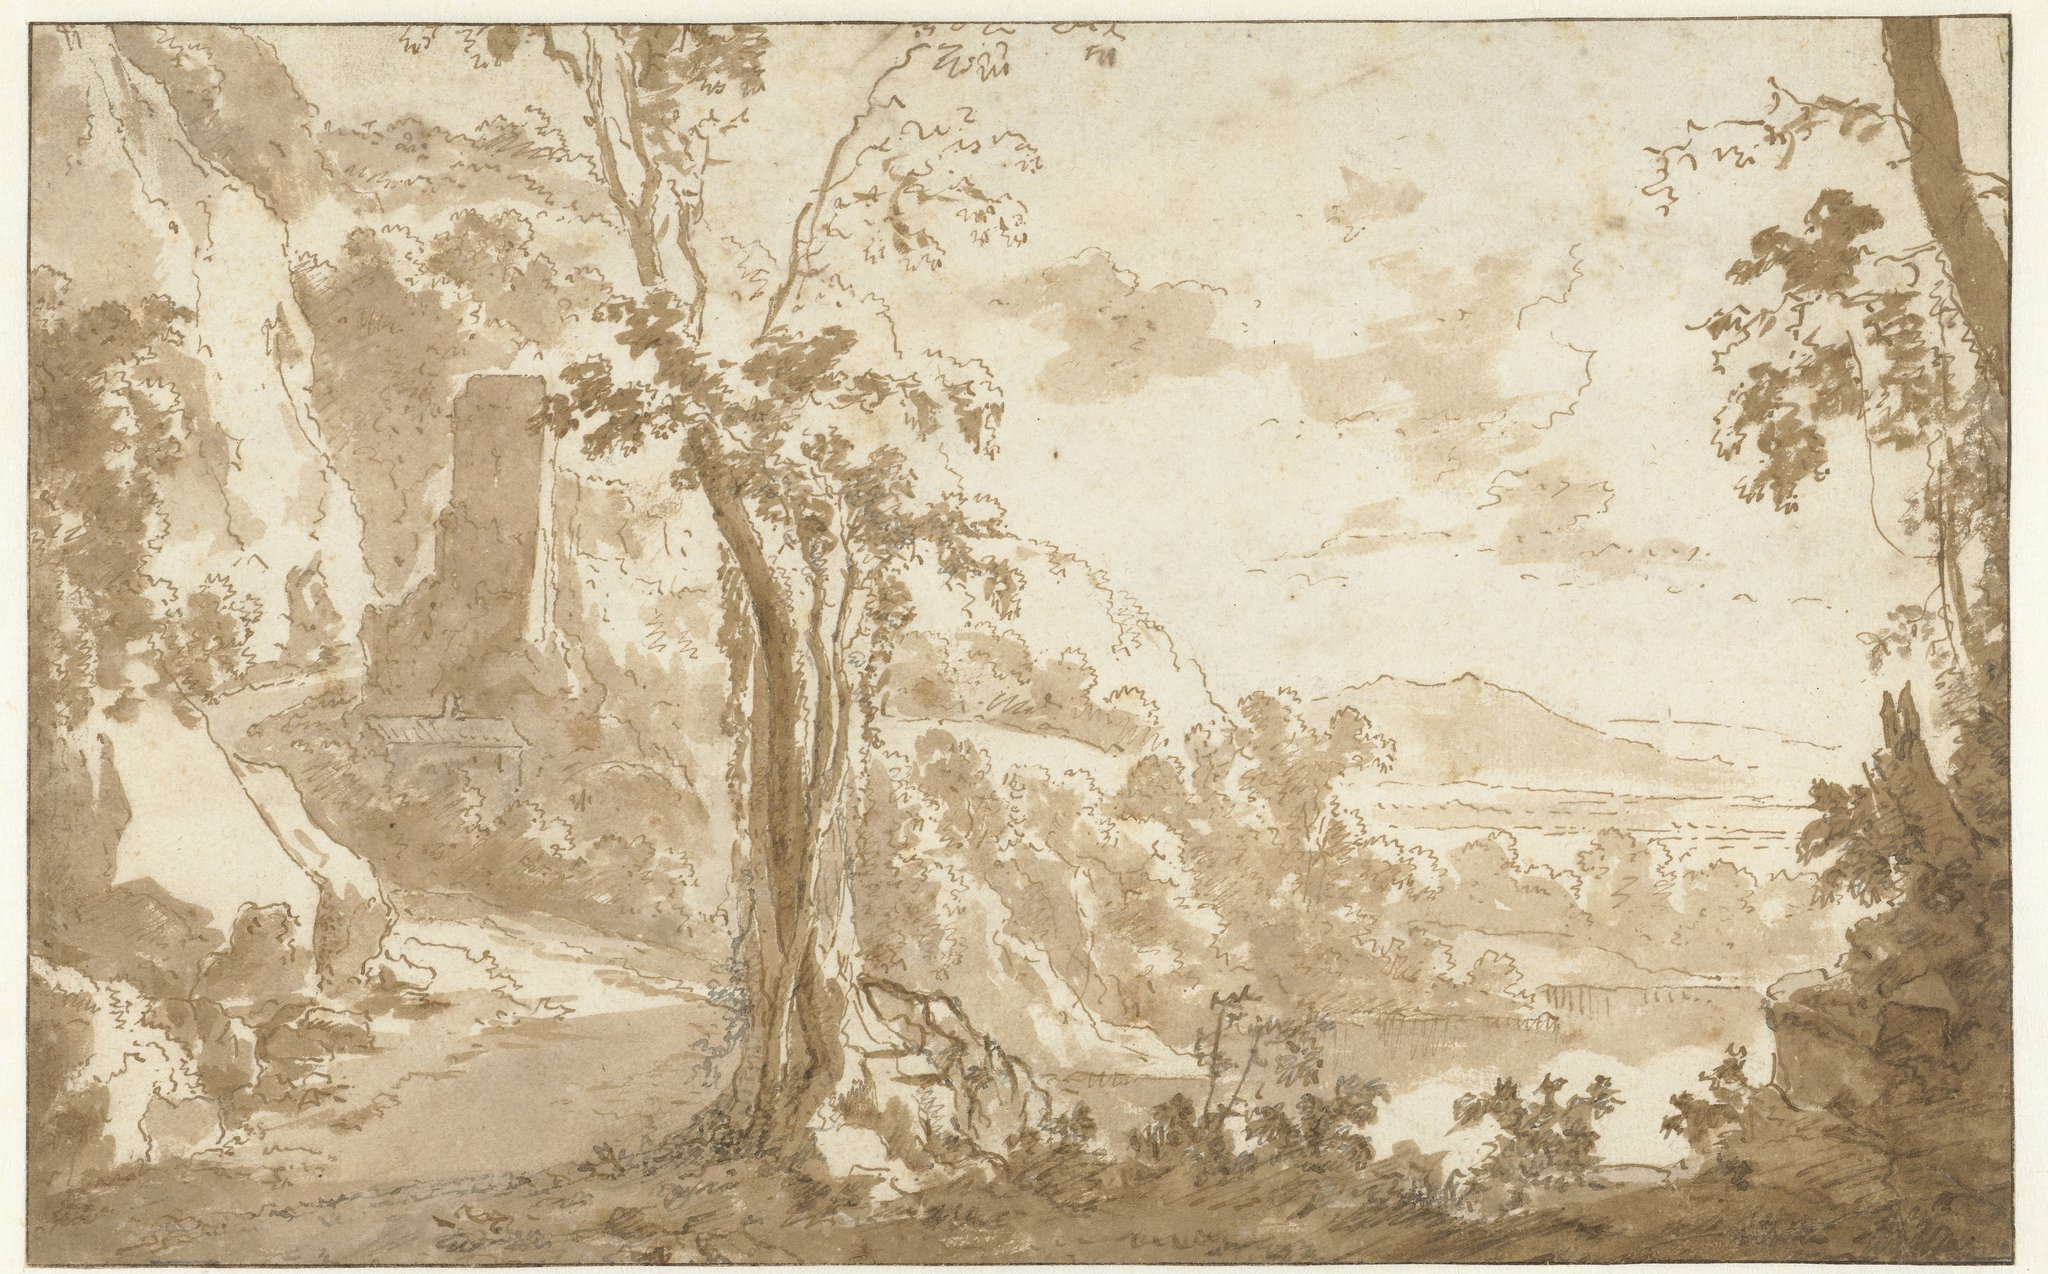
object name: drawing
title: Berglandschap met een weg langs een meer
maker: jan both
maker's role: draughtsman, painter, print maker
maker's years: 1618-1652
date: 1628-1652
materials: ink, paper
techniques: brush, pen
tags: (high) hill, lake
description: Italiaans berglandschap met een ruïne aan een opgaande weg links en in de diepte, rechts, een meer.